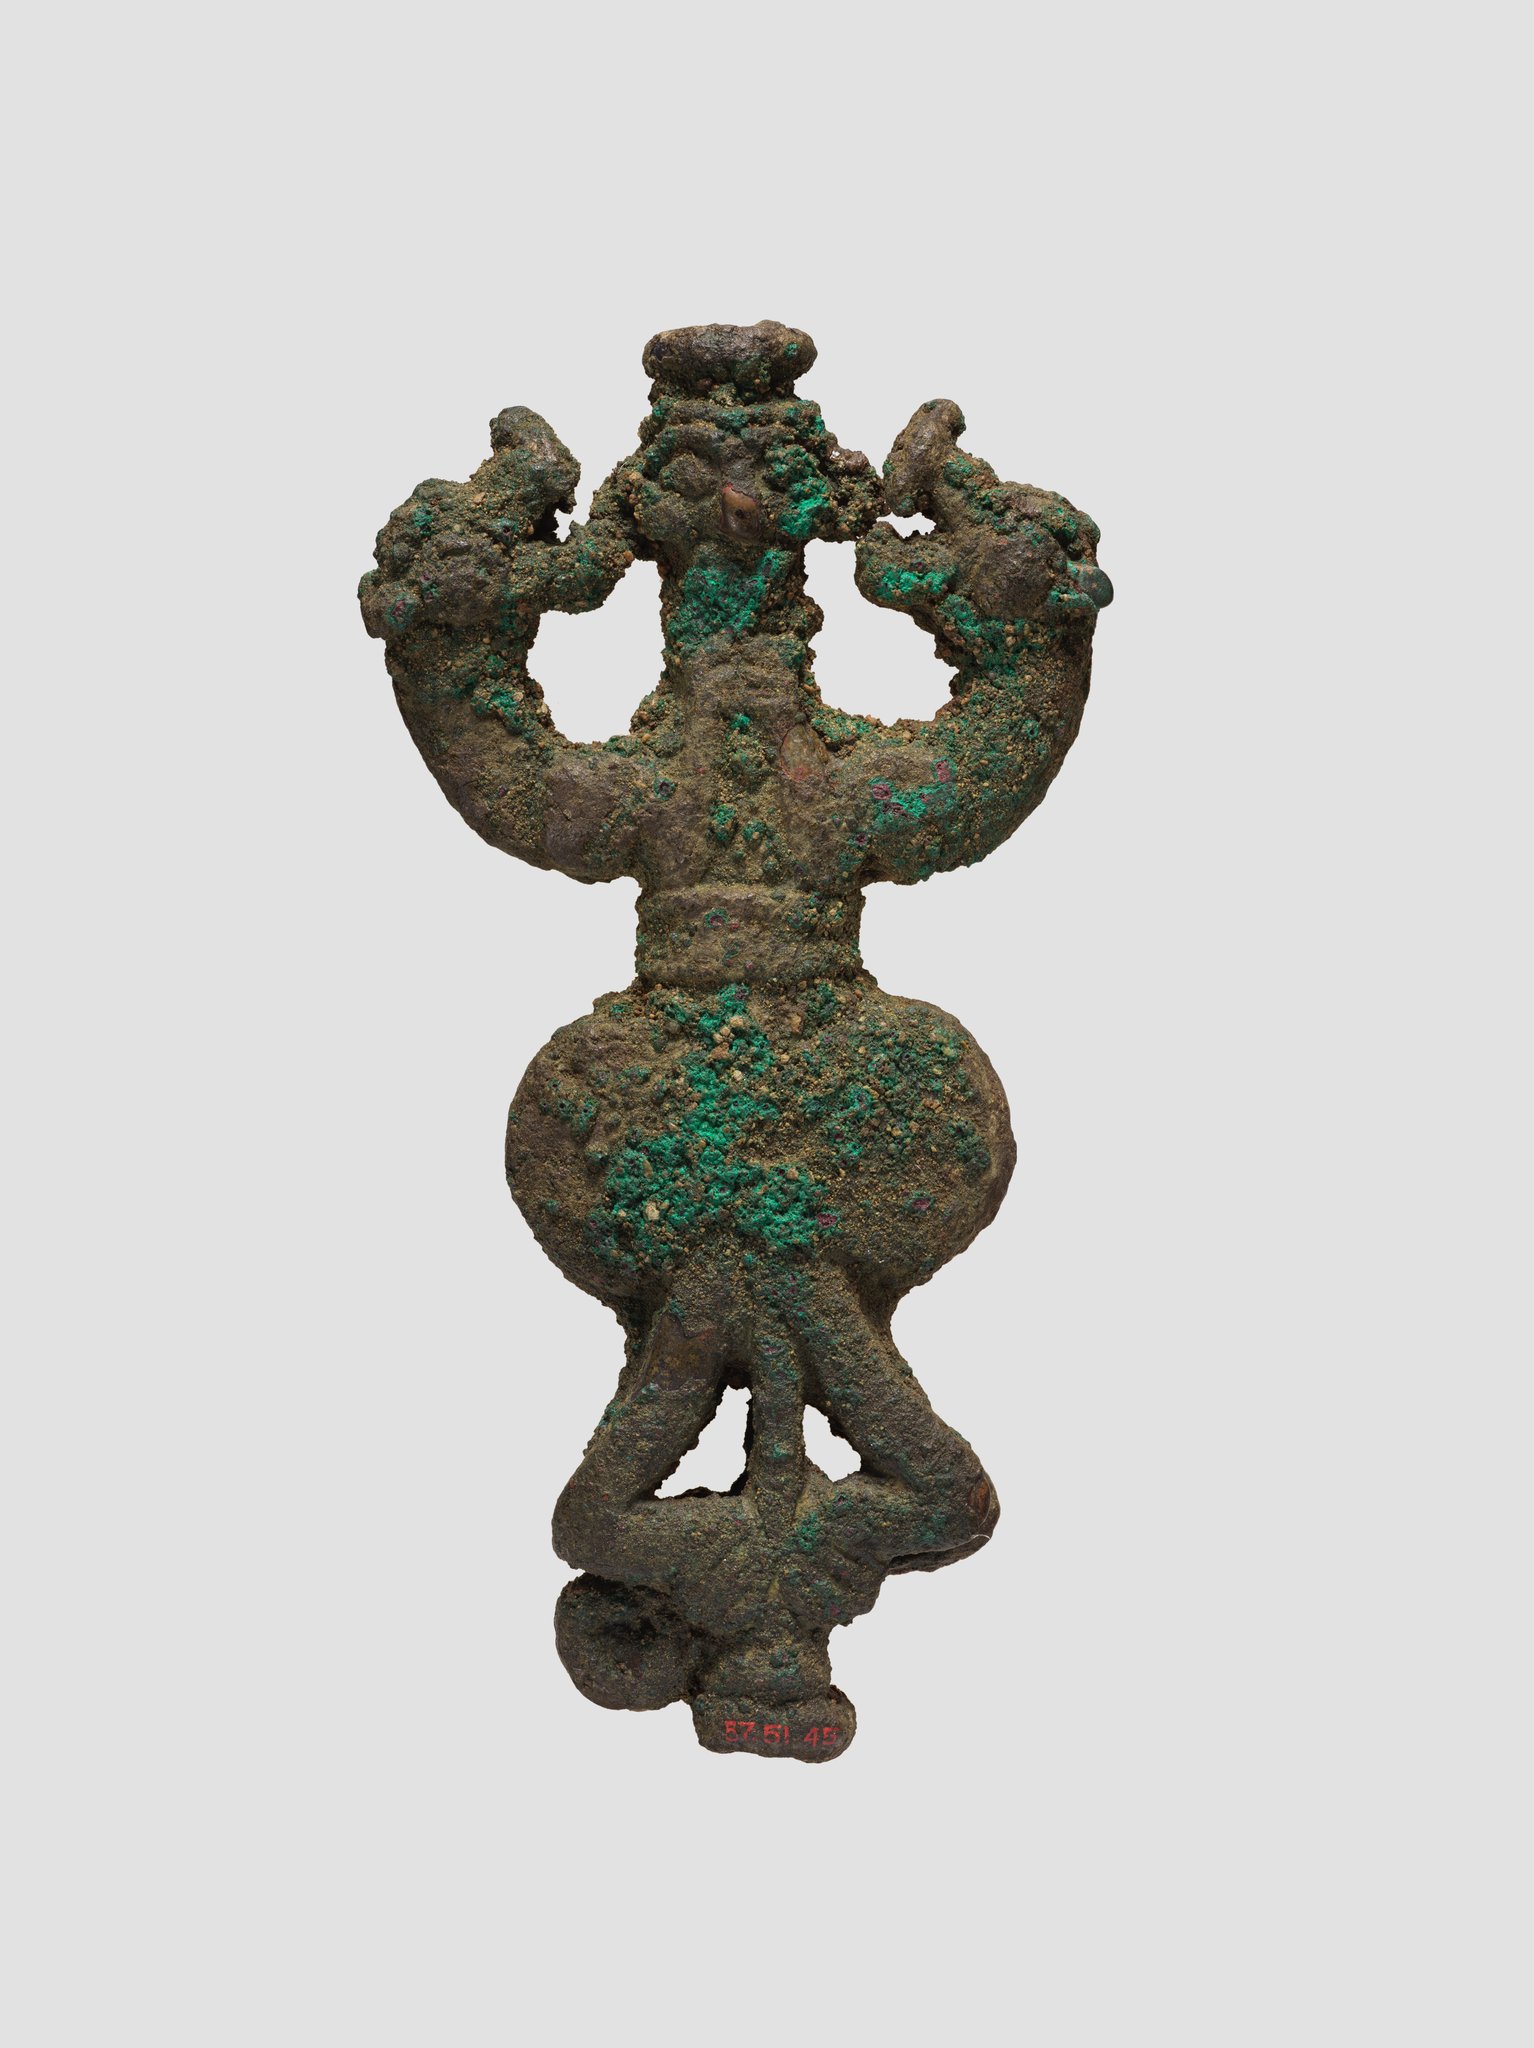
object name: sculpture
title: Top for standard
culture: iranian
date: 800-601 BCE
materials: bronze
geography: iran, probably from luristan